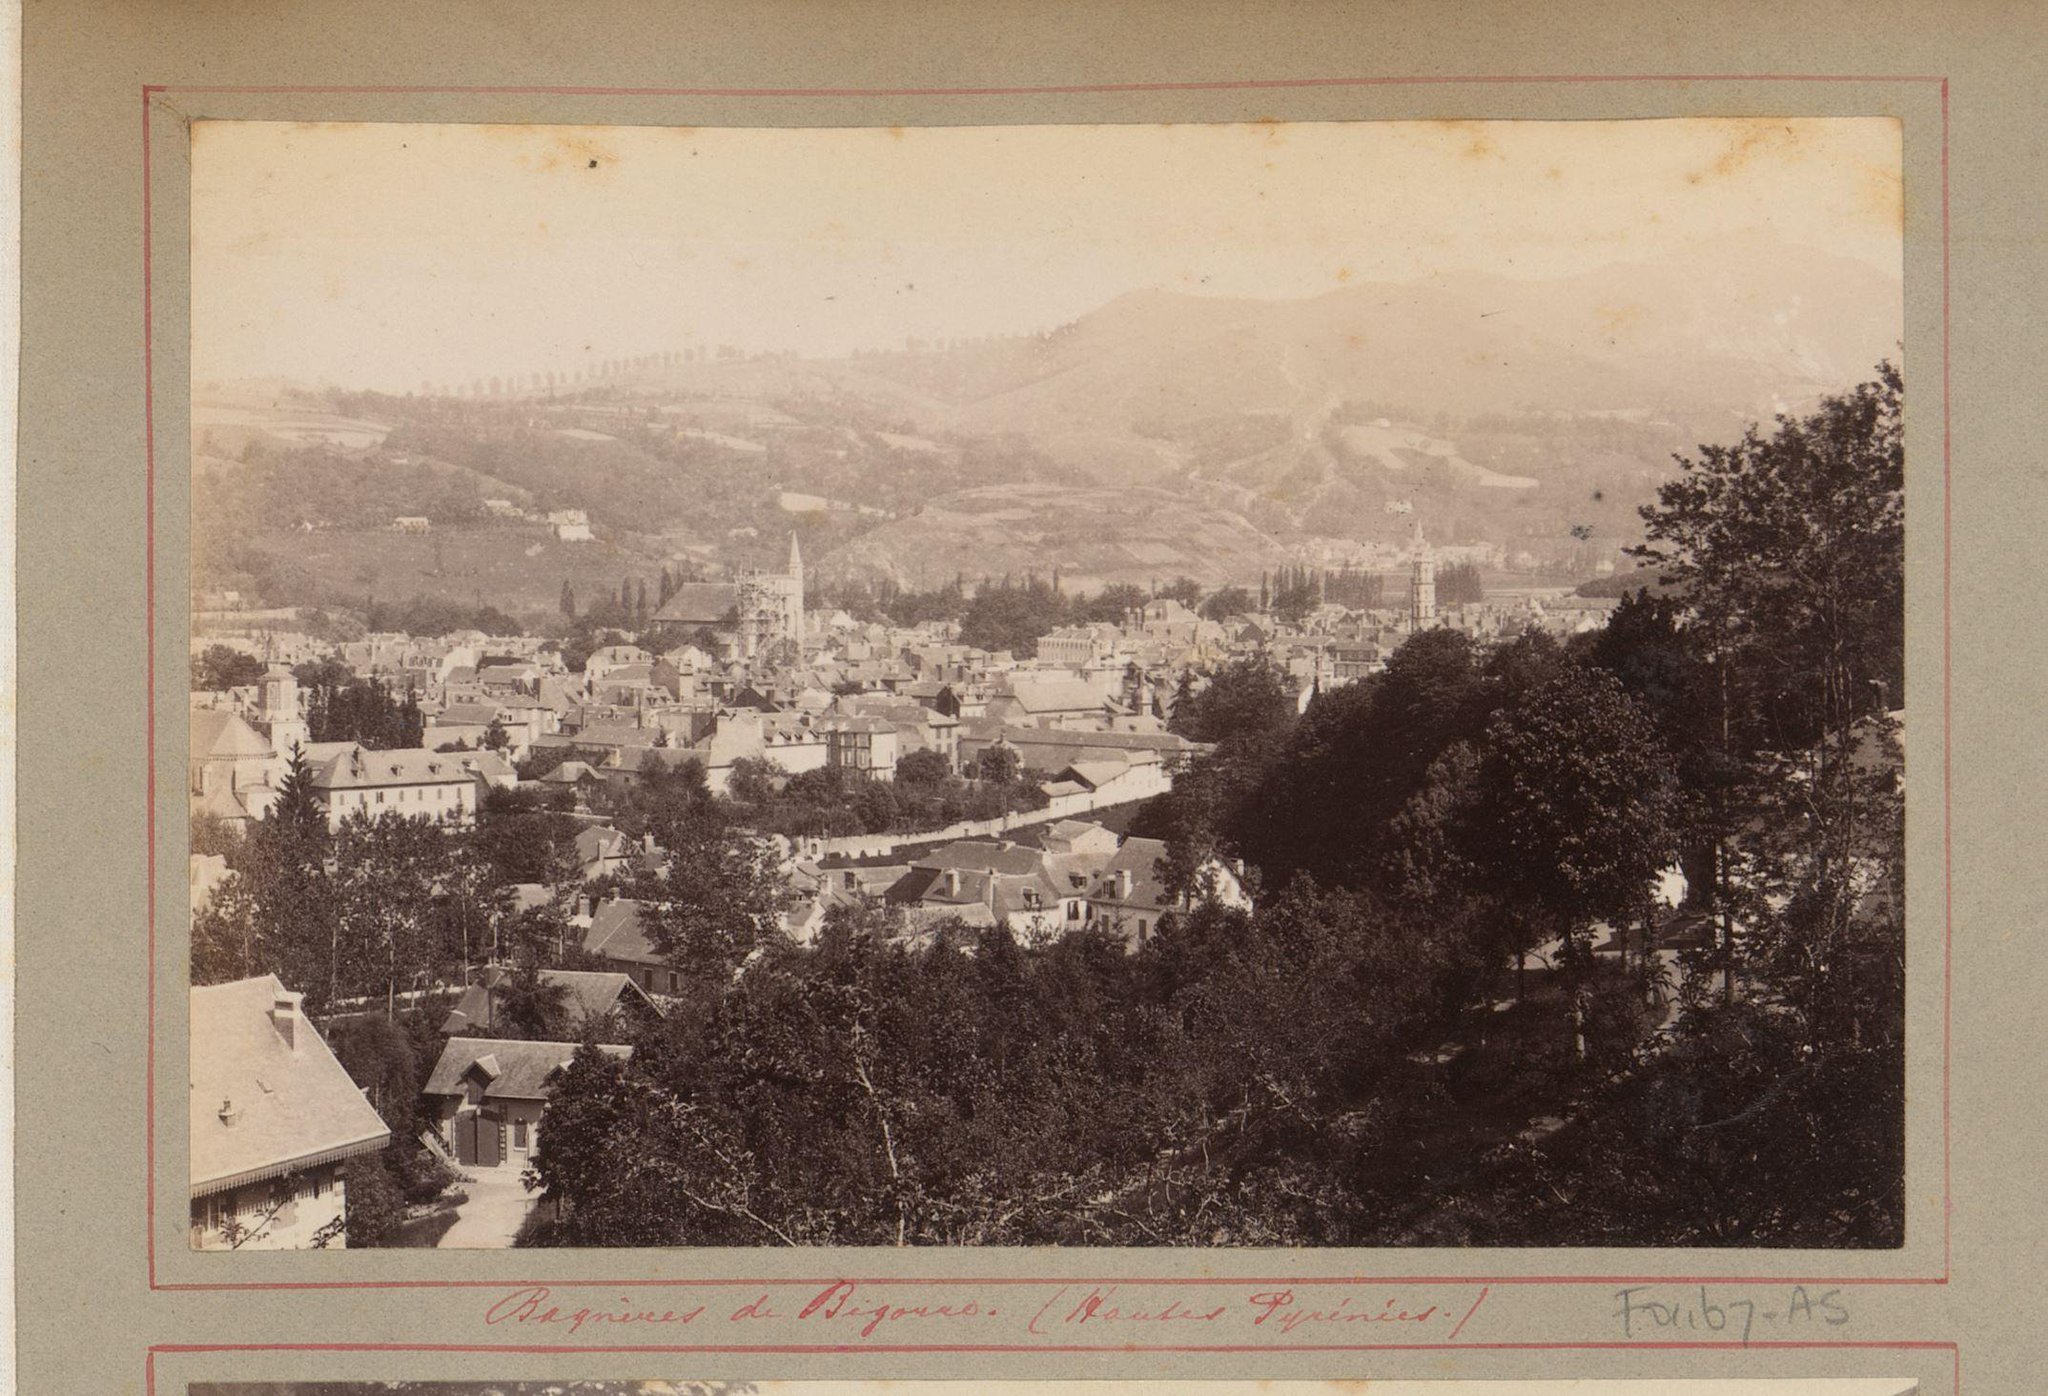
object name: album leaf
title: Stadsgezicht met op de achtergrond bergen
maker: Anonymous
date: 1880-1910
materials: photographic support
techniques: albumen print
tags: city-view in general; 'veduta', mountains, france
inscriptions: annotation: ‘[...]’